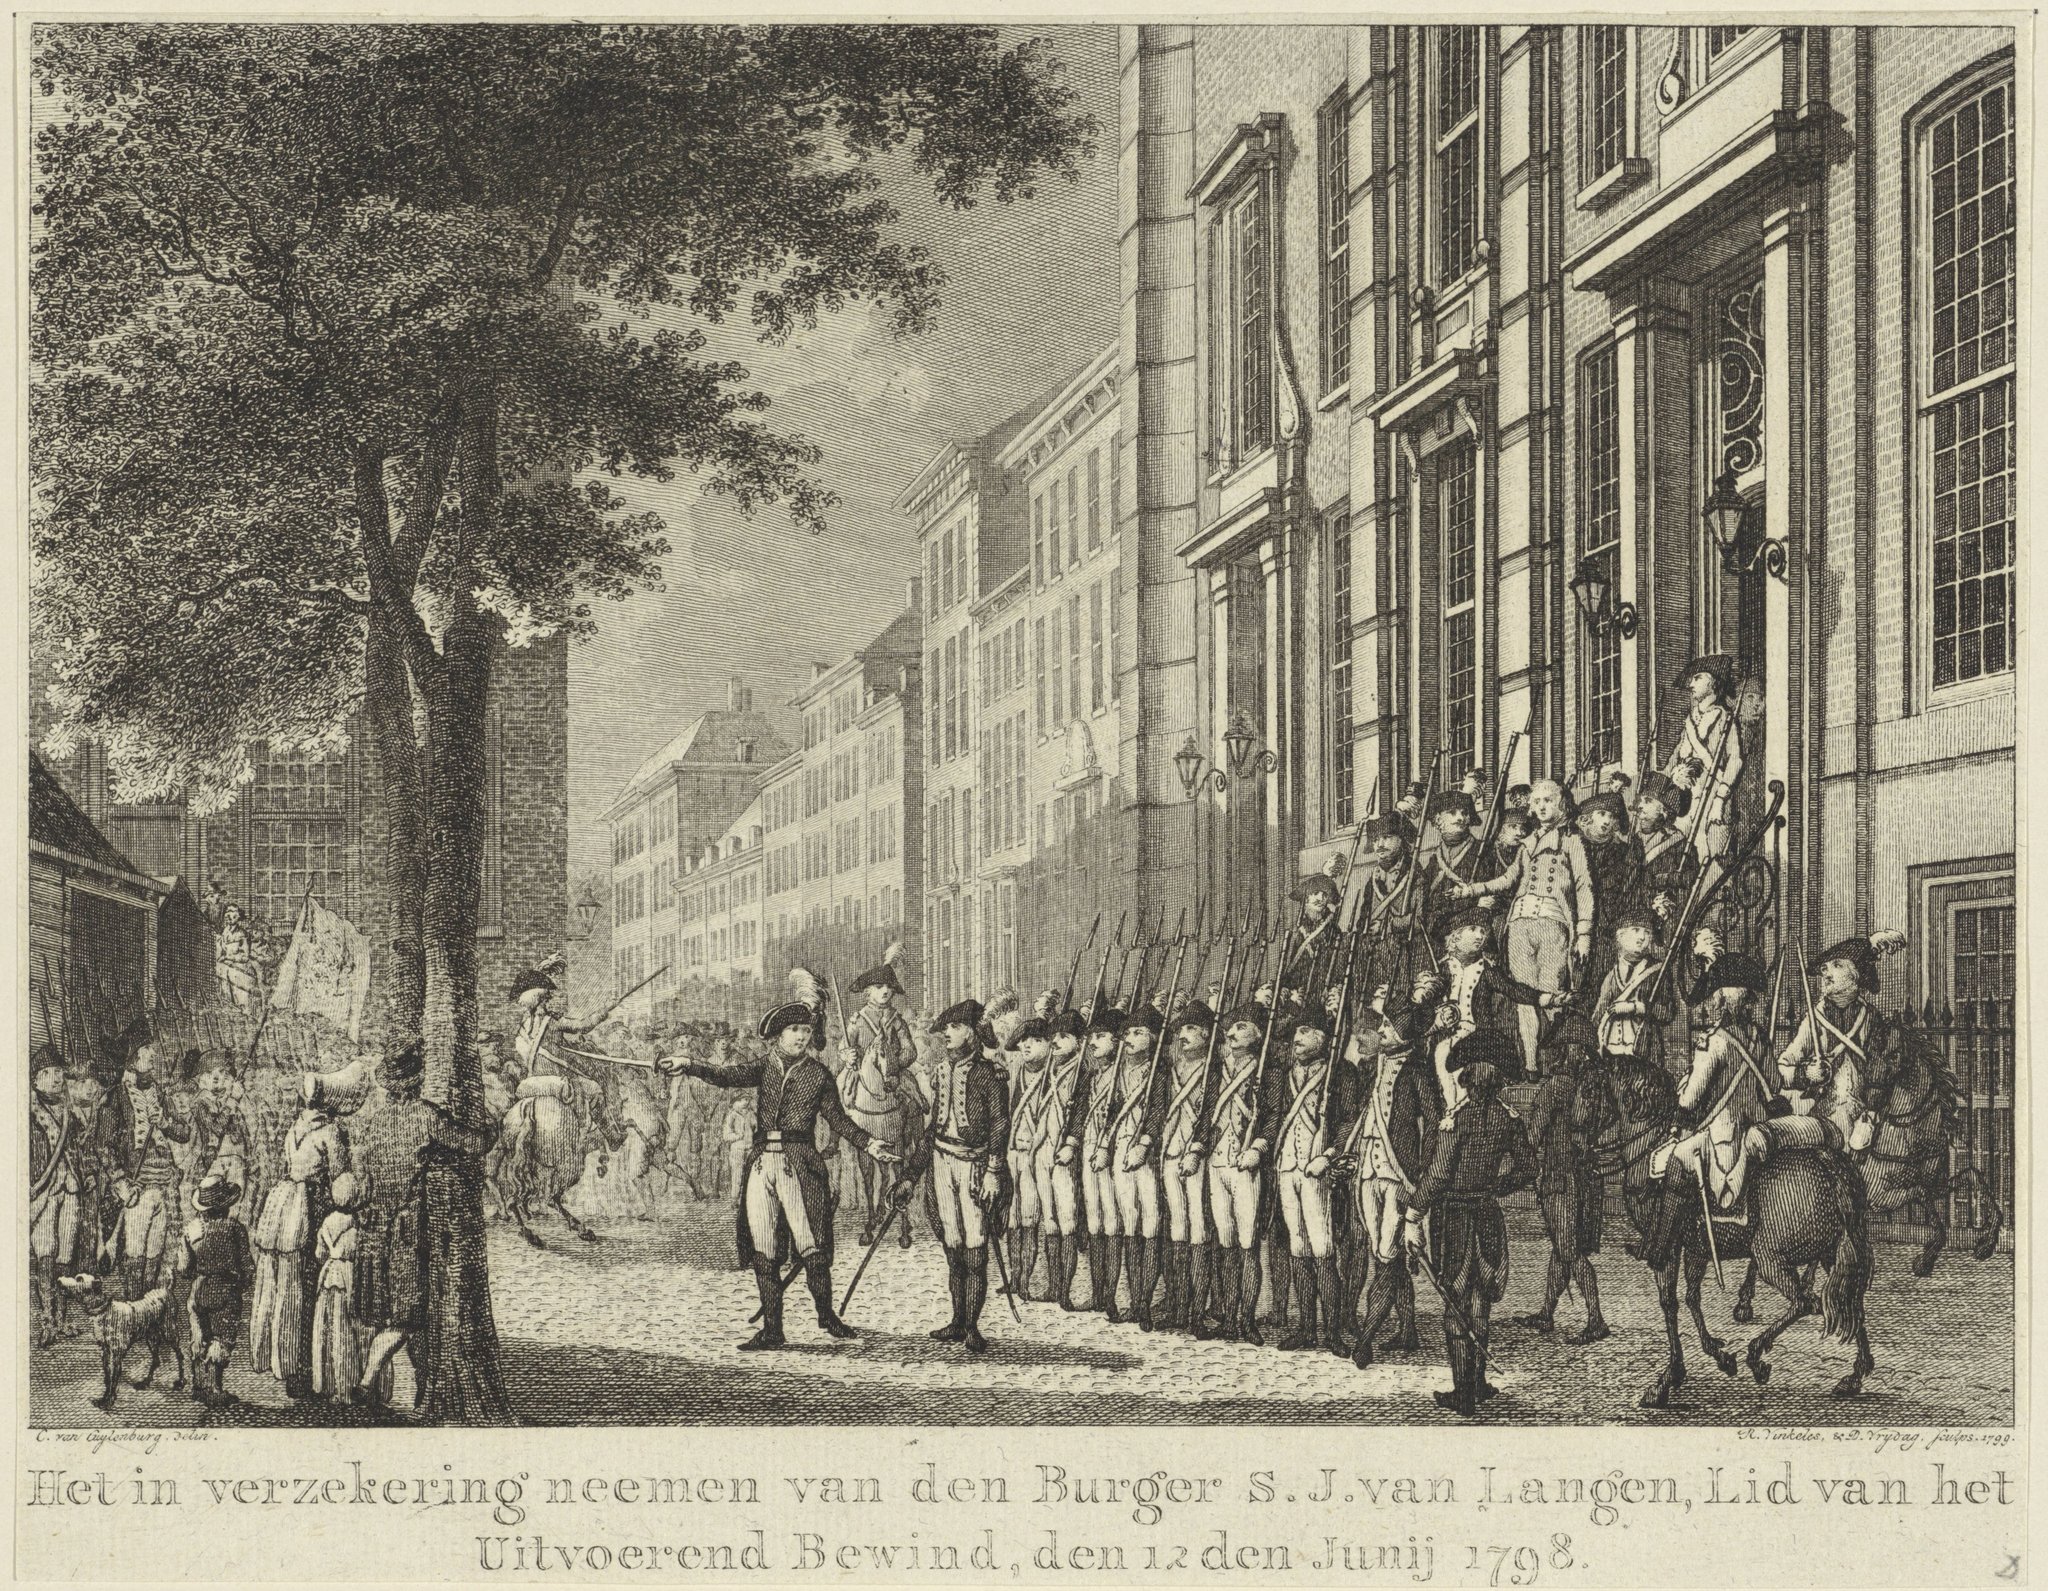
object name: history print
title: Arrestatie van S.J van Langen, 1798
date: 1799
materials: paper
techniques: engraving, etching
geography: amsterdam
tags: leiden, arrest (of criminal)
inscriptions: date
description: Arrestatie van Stephanus Jacobus van Langen, lid van het Uitvoerend Bewind, door een detachement militairen vóór het Logement aan het Plein te Den Haag,12 juni 1798. Op beschuldiging van zelfverrijking.